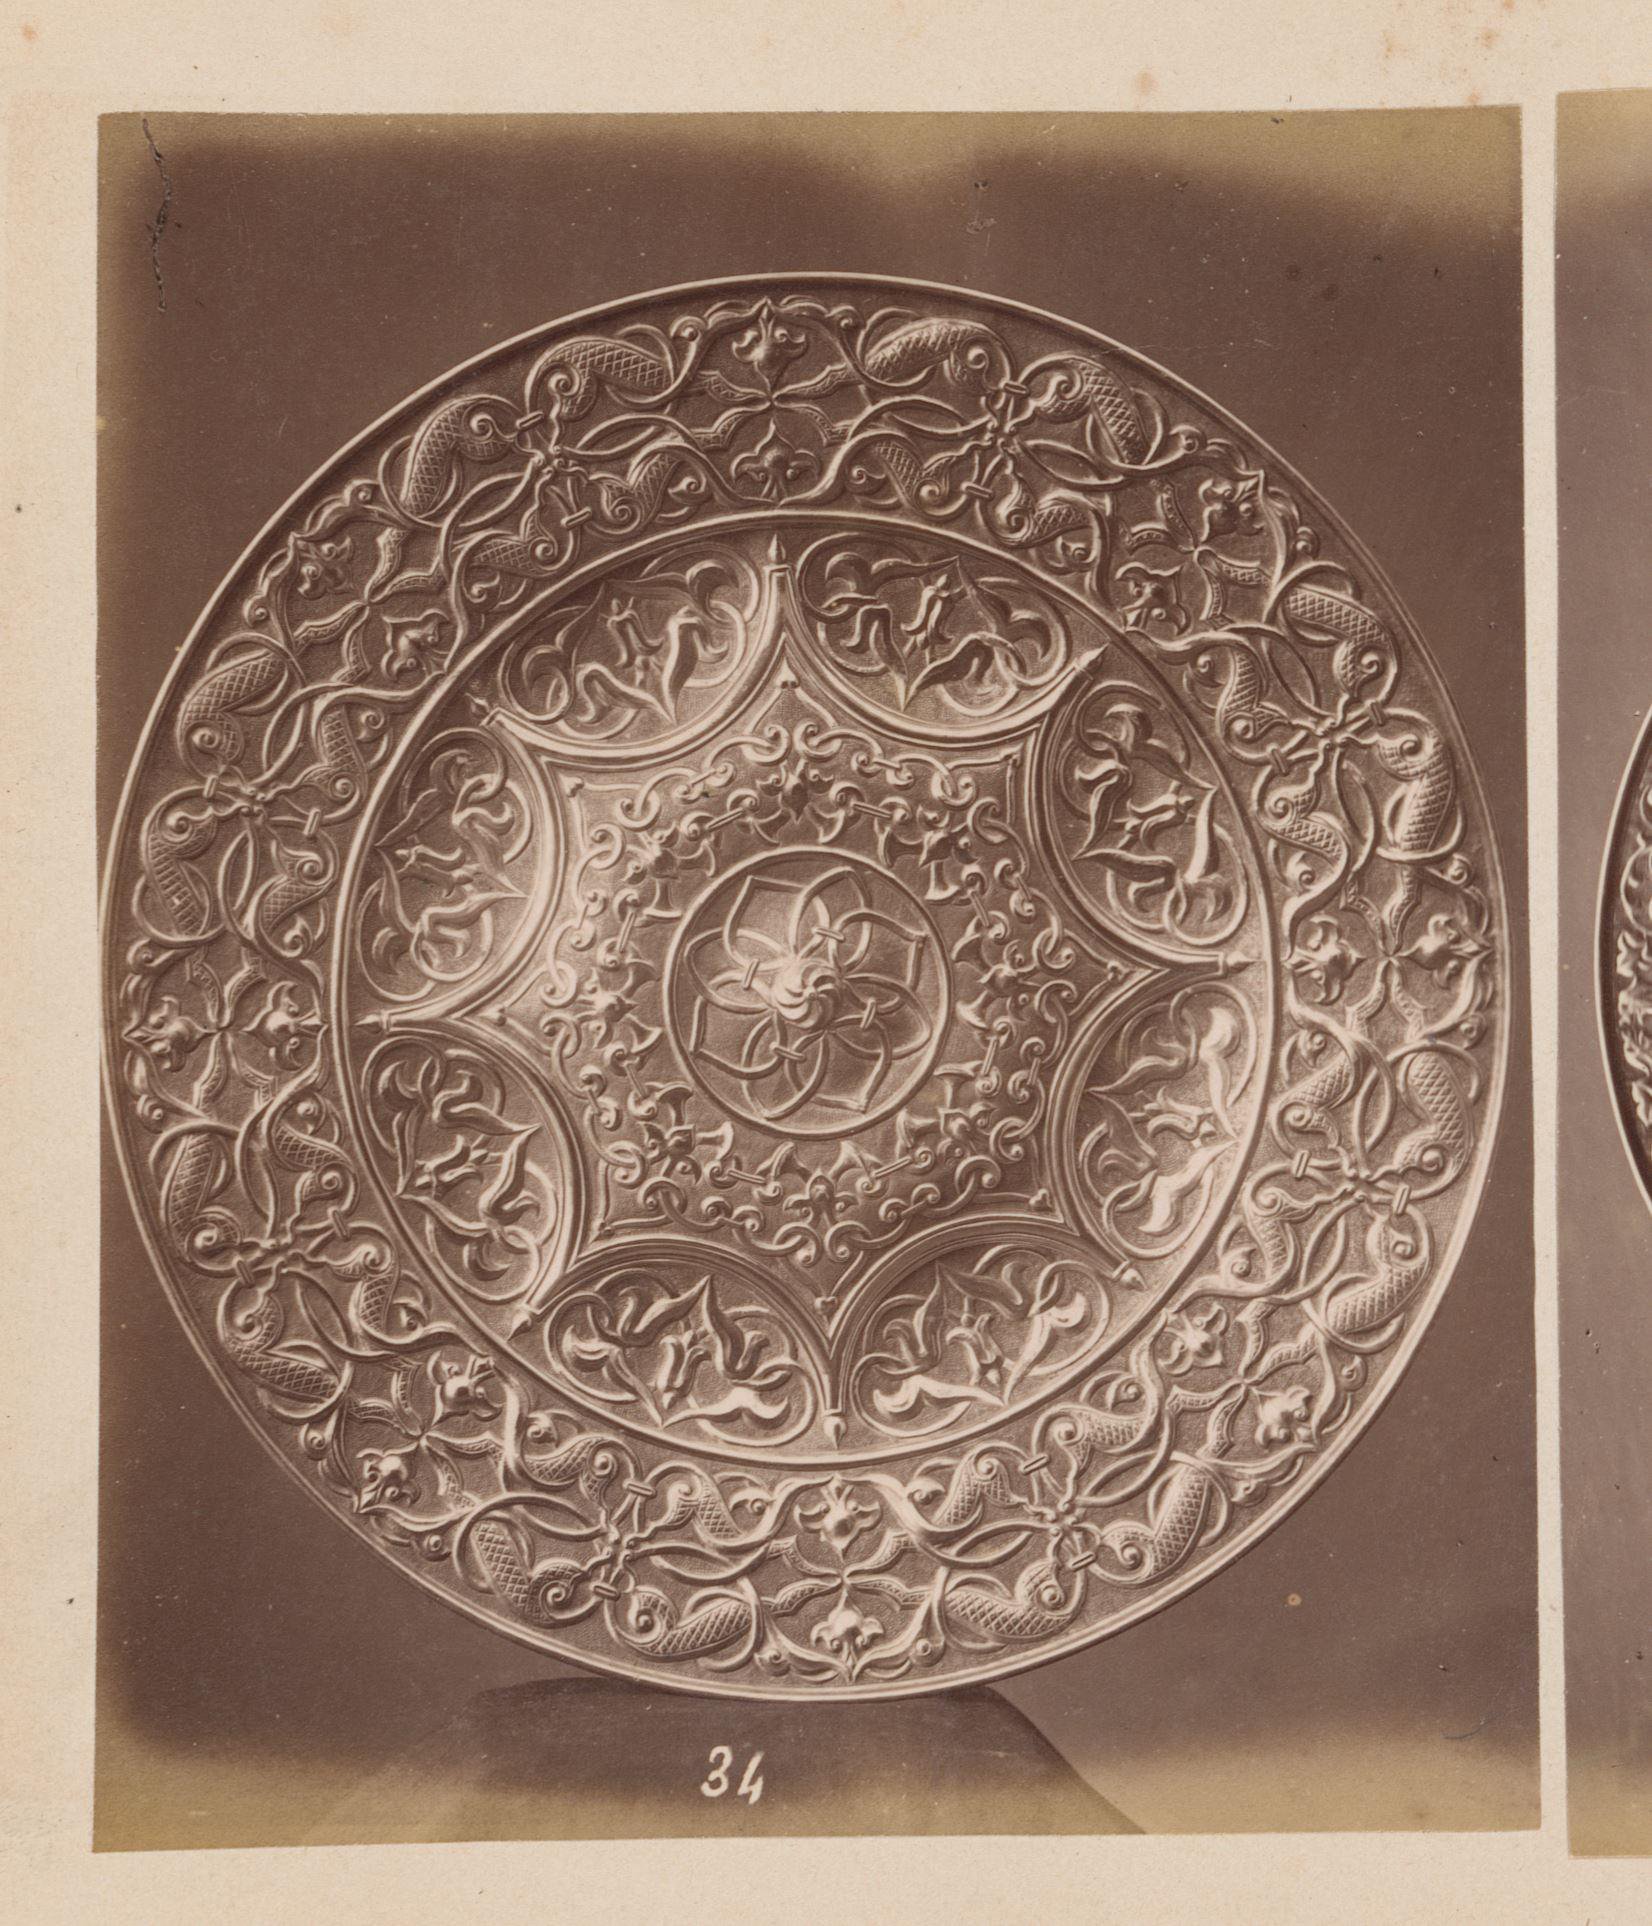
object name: photograph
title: Metalen schotel met Arabische motieven, uit de 15de of 16de eeuw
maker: Anonymous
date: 1860-1885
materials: photographic support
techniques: albumen print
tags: serving-dish, platter